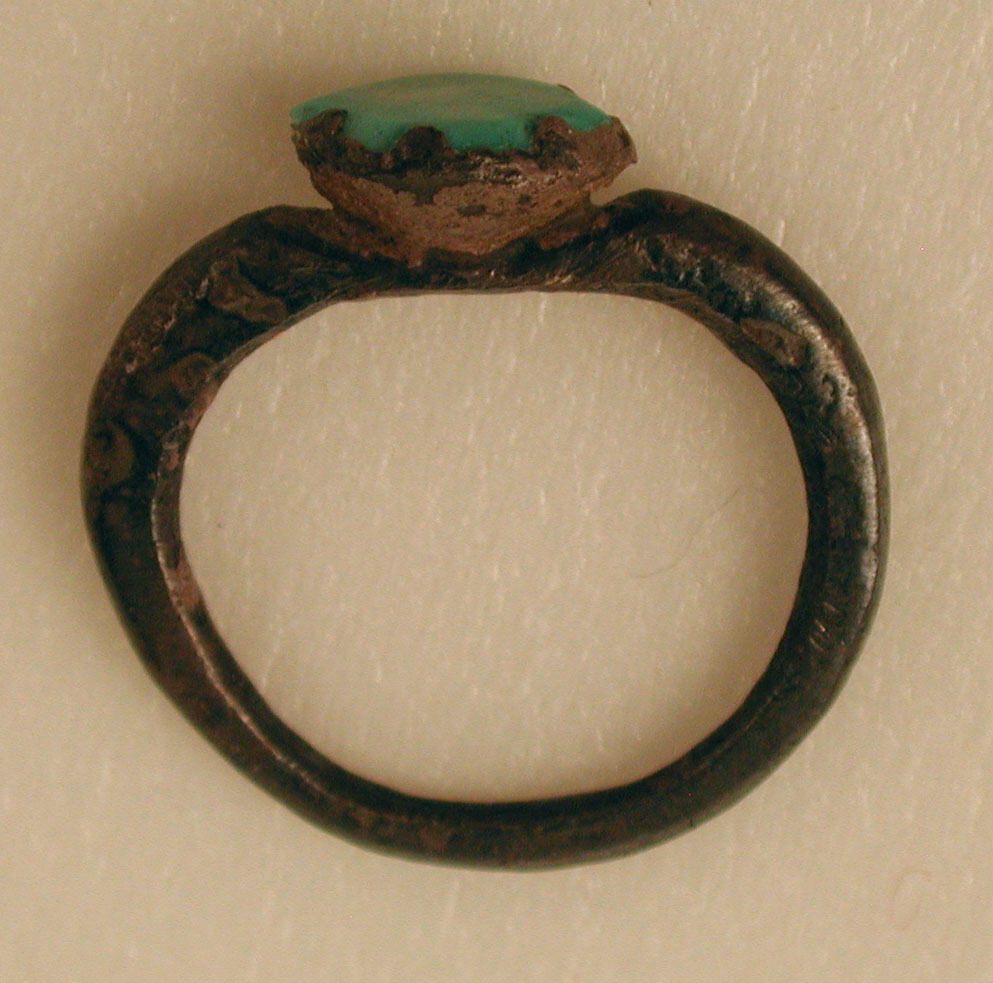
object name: ring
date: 801-1100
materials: silver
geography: iran